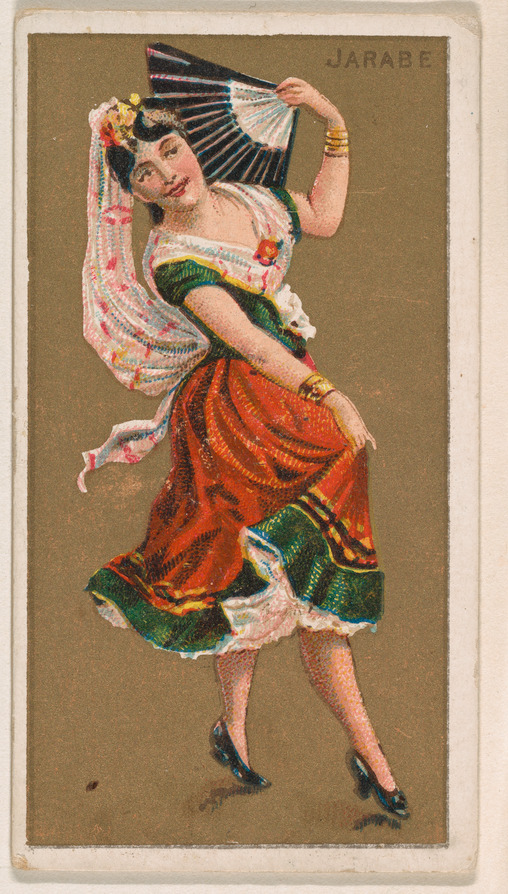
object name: print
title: Jarabe, from National Dances (N225, Type 1) issued by Kinney Bros.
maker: kinney brothers tobacco company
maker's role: publisher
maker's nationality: american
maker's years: 1869-2011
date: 1889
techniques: color lithograph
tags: women,dancers